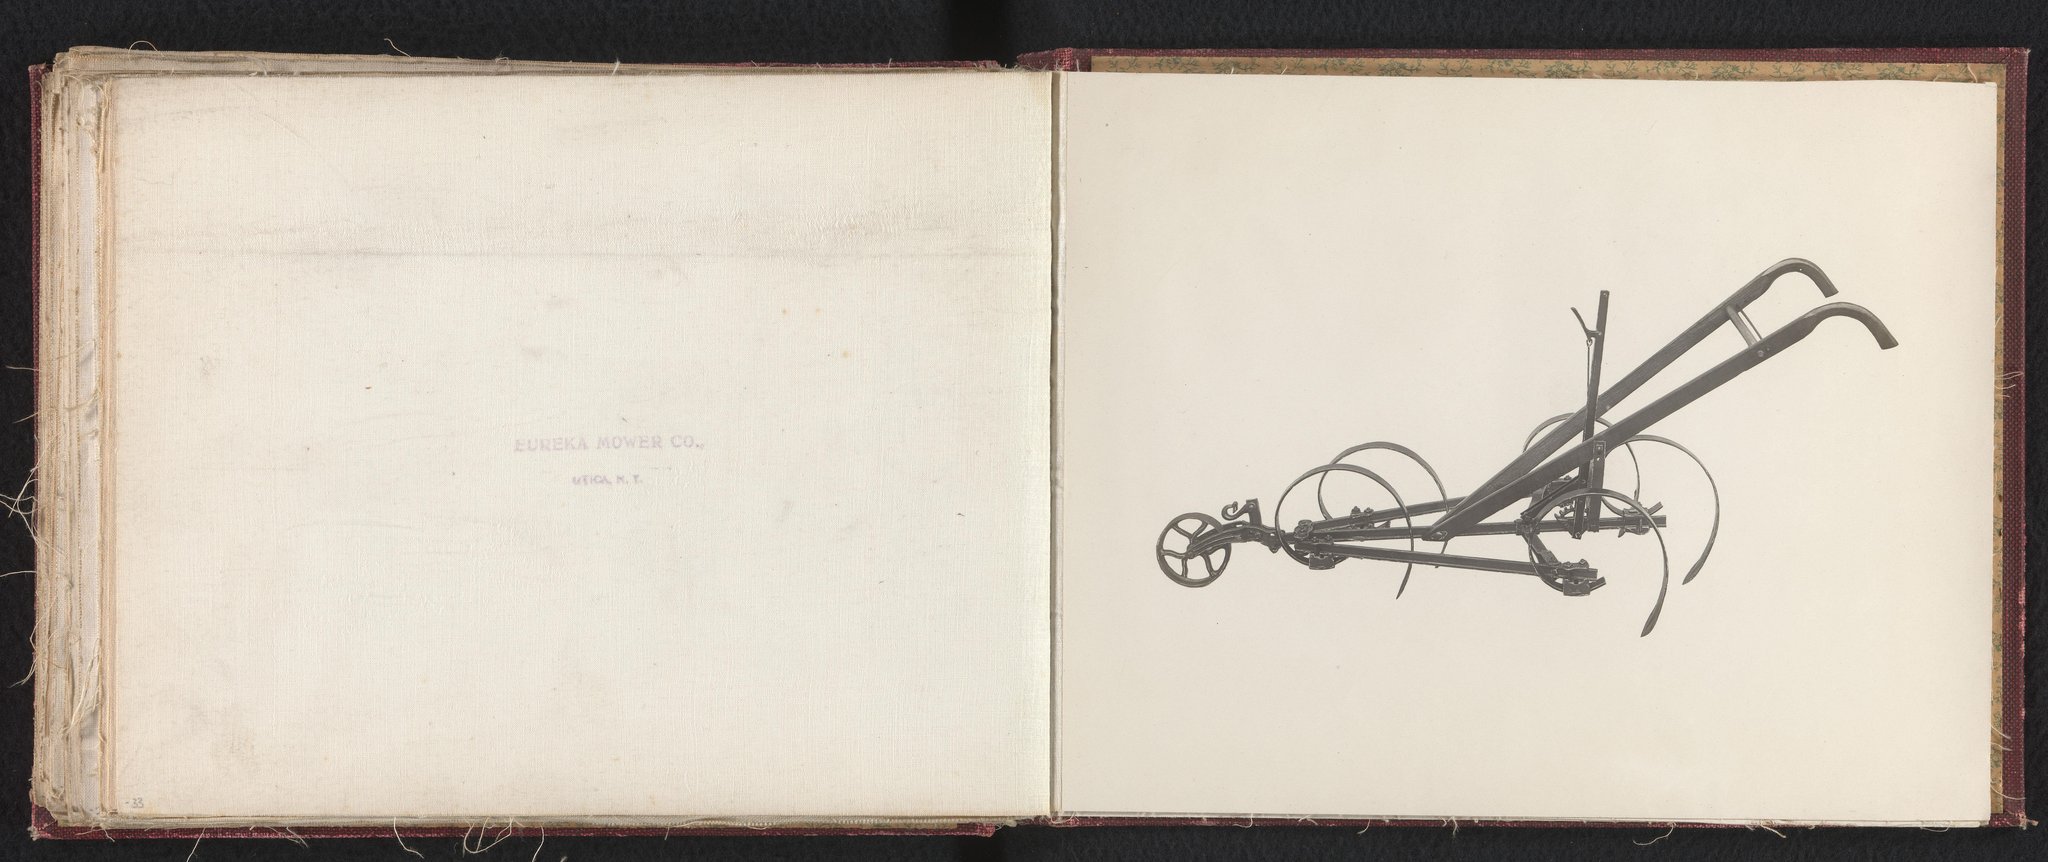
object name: page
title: Landbouwwerktuig van de Eureka Mower Co. te Utrica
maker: lewis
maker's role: fotograaf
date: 1915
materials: paper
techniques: gelatin silver print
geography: utica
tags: agricultural implements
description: Foto op 31e ongenummerde pagina na voorplat.